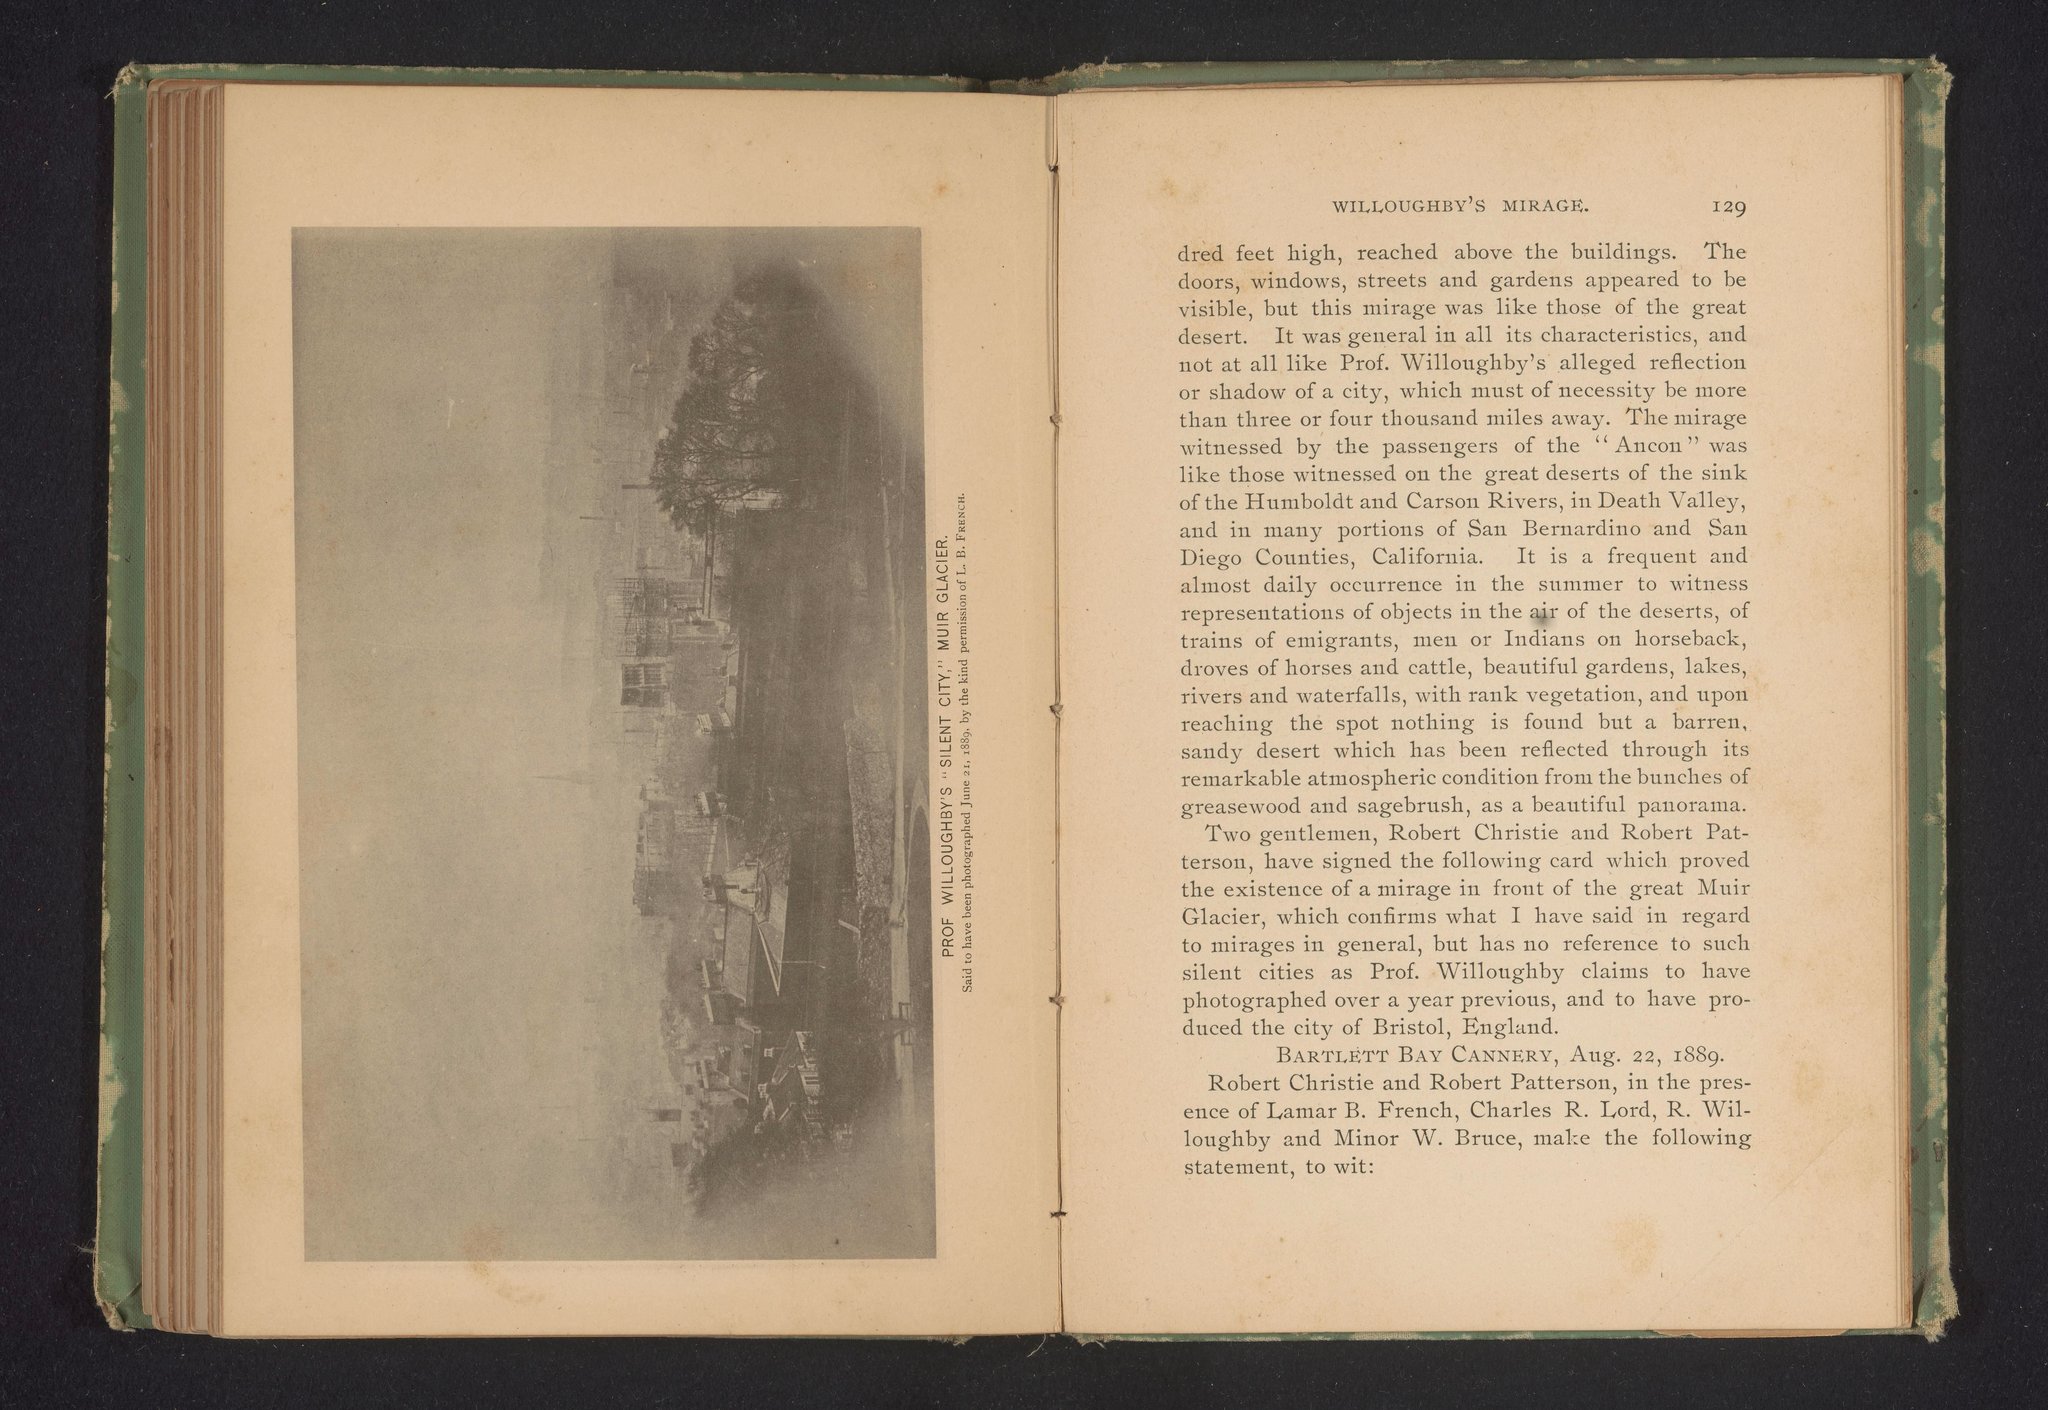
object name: page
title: Gezicht op de imaginaire stad Silent City in Alaska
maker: Anonymous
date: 1885-1890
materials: paper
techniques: photograph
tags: city-view in general; 'veduta'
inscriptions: inscription: ‘Said to be photographed June 21, 1889, by the kind permission of L.B. French.’